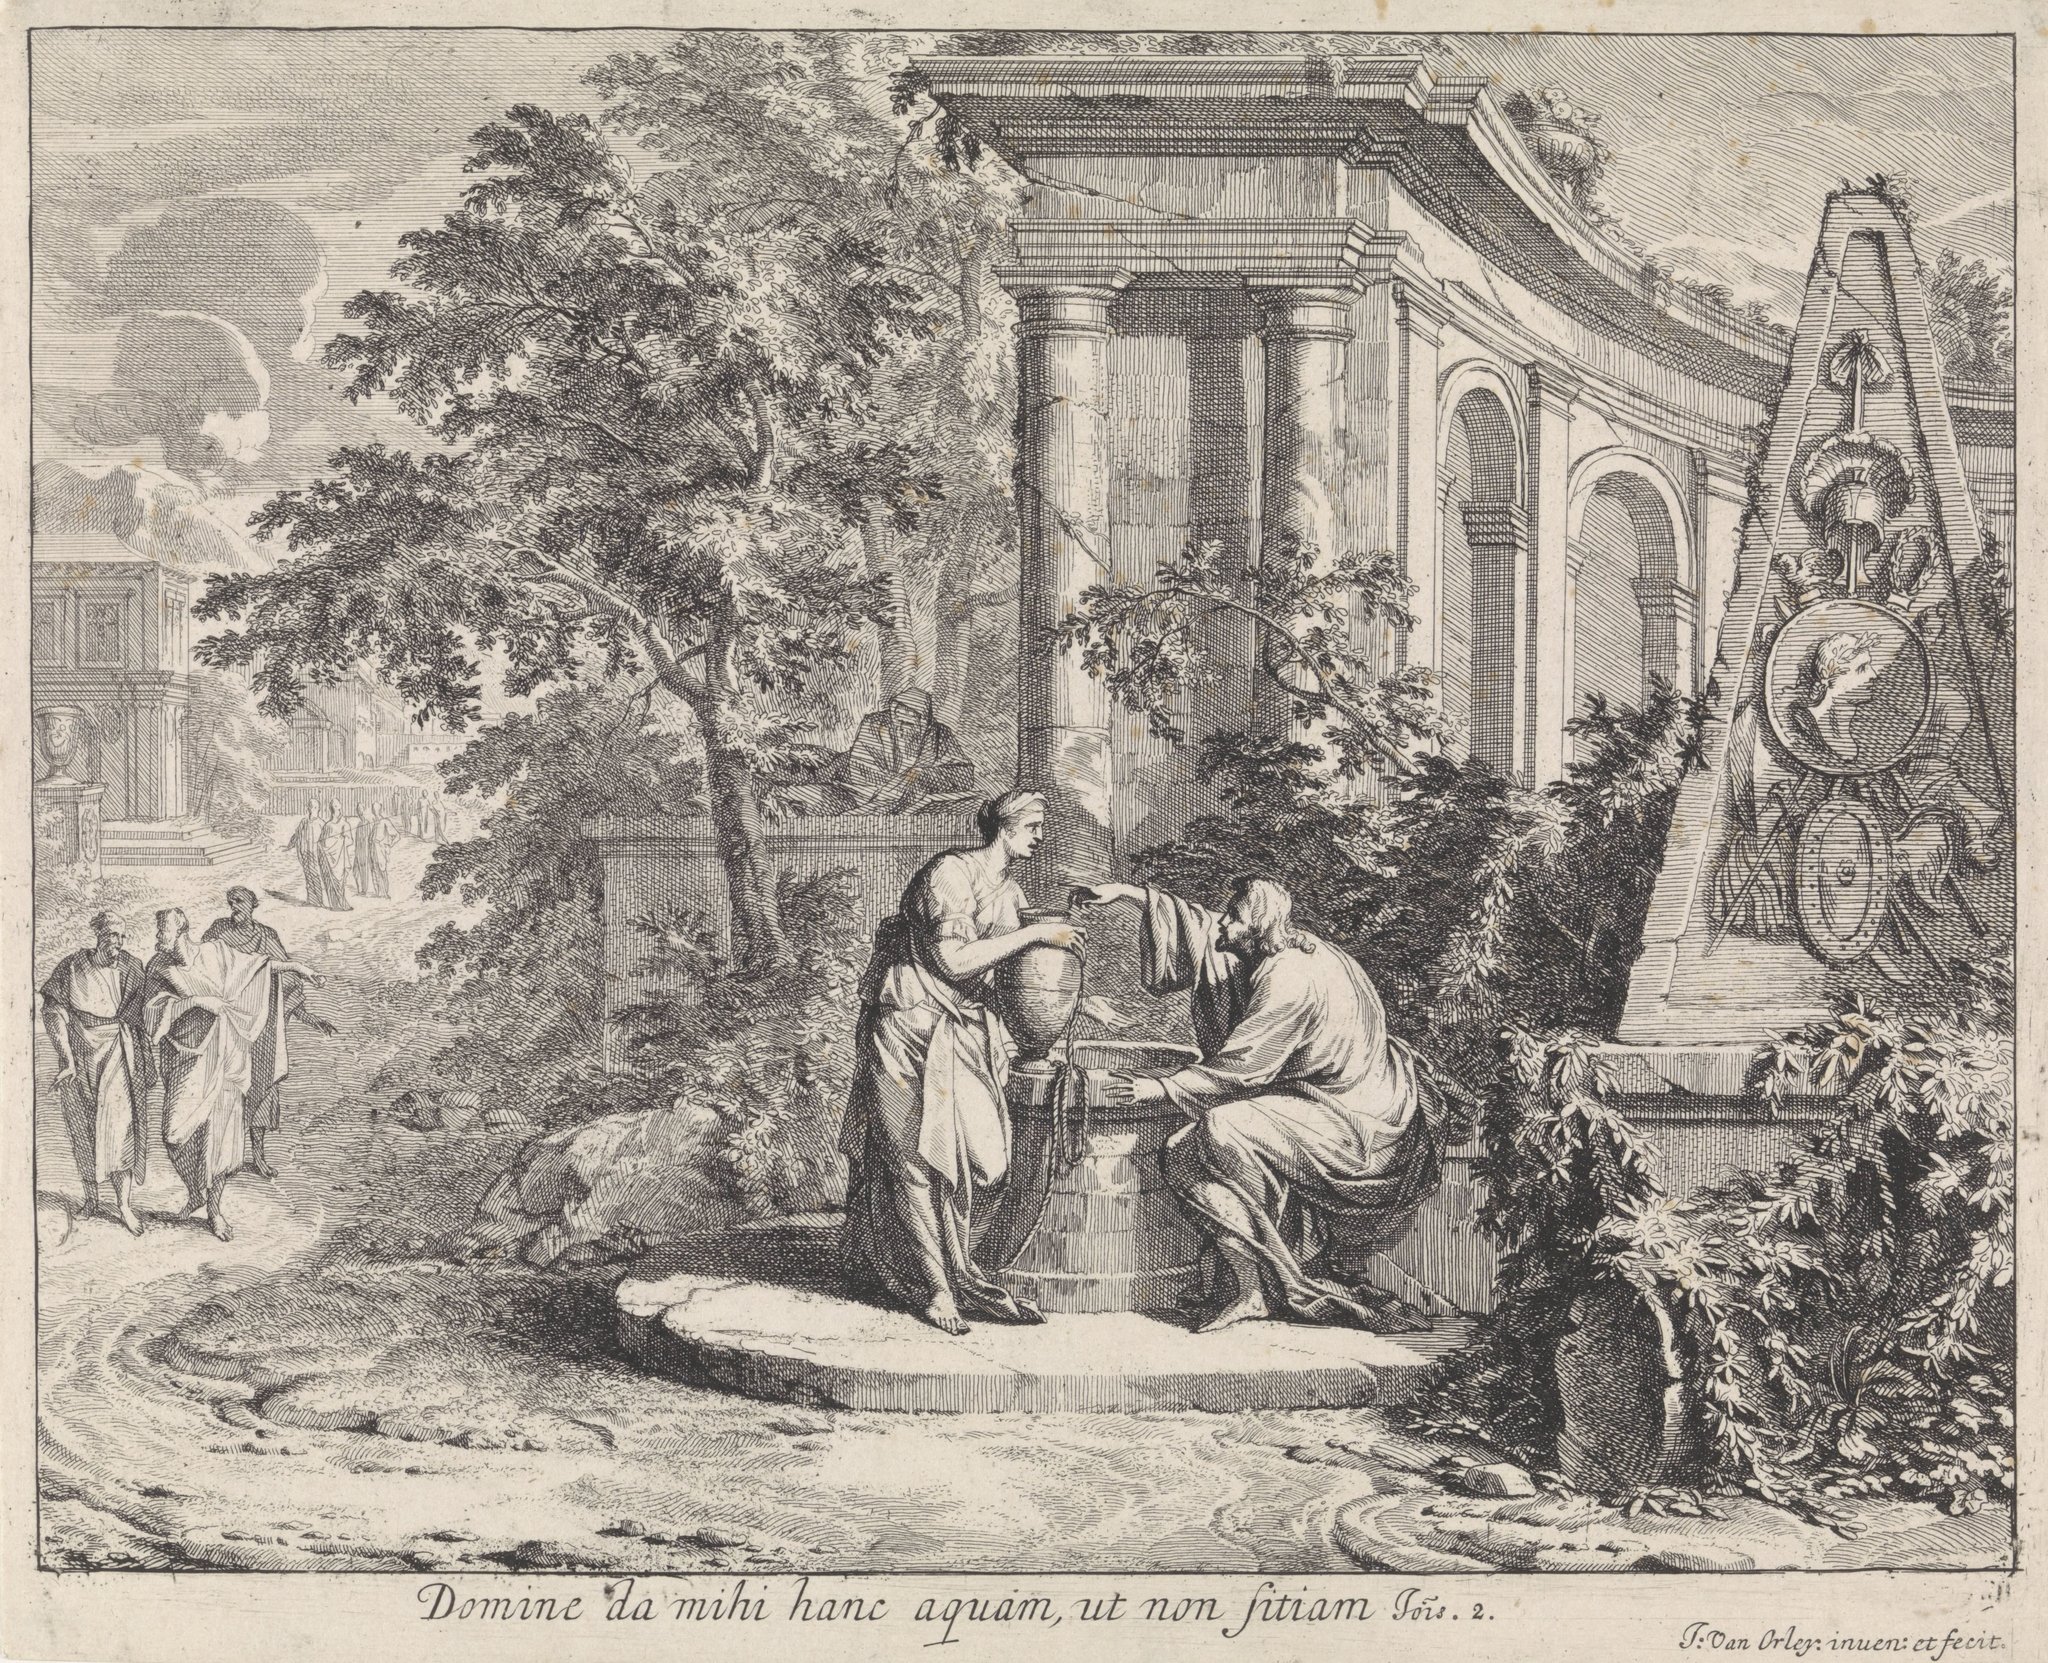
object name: print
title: Christus en de Samaritaanse vrouw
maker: jan van orley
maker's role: print maker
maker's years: 1665-1735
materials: paper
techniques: engraving, etching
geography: brussels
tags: christ and the woman of samaria: sitting at jacob's well he asks her for a drink from her jug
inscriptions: collector's mark: Lugt 240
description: Christus zit bij een bron. Een Samaritaanse vrouw biedt hem uit haar kruik water te drinken aan. Rechts een Romeins monument en een zuilengalerij tussen bomen. Onder de afbeelding een Latijns vers uit Joh. 4.